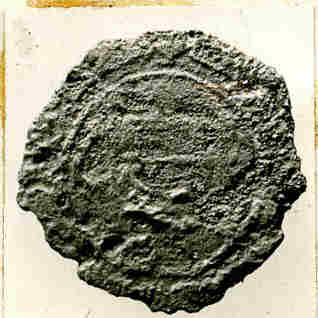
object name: coin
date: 153-770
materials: copper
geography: iran